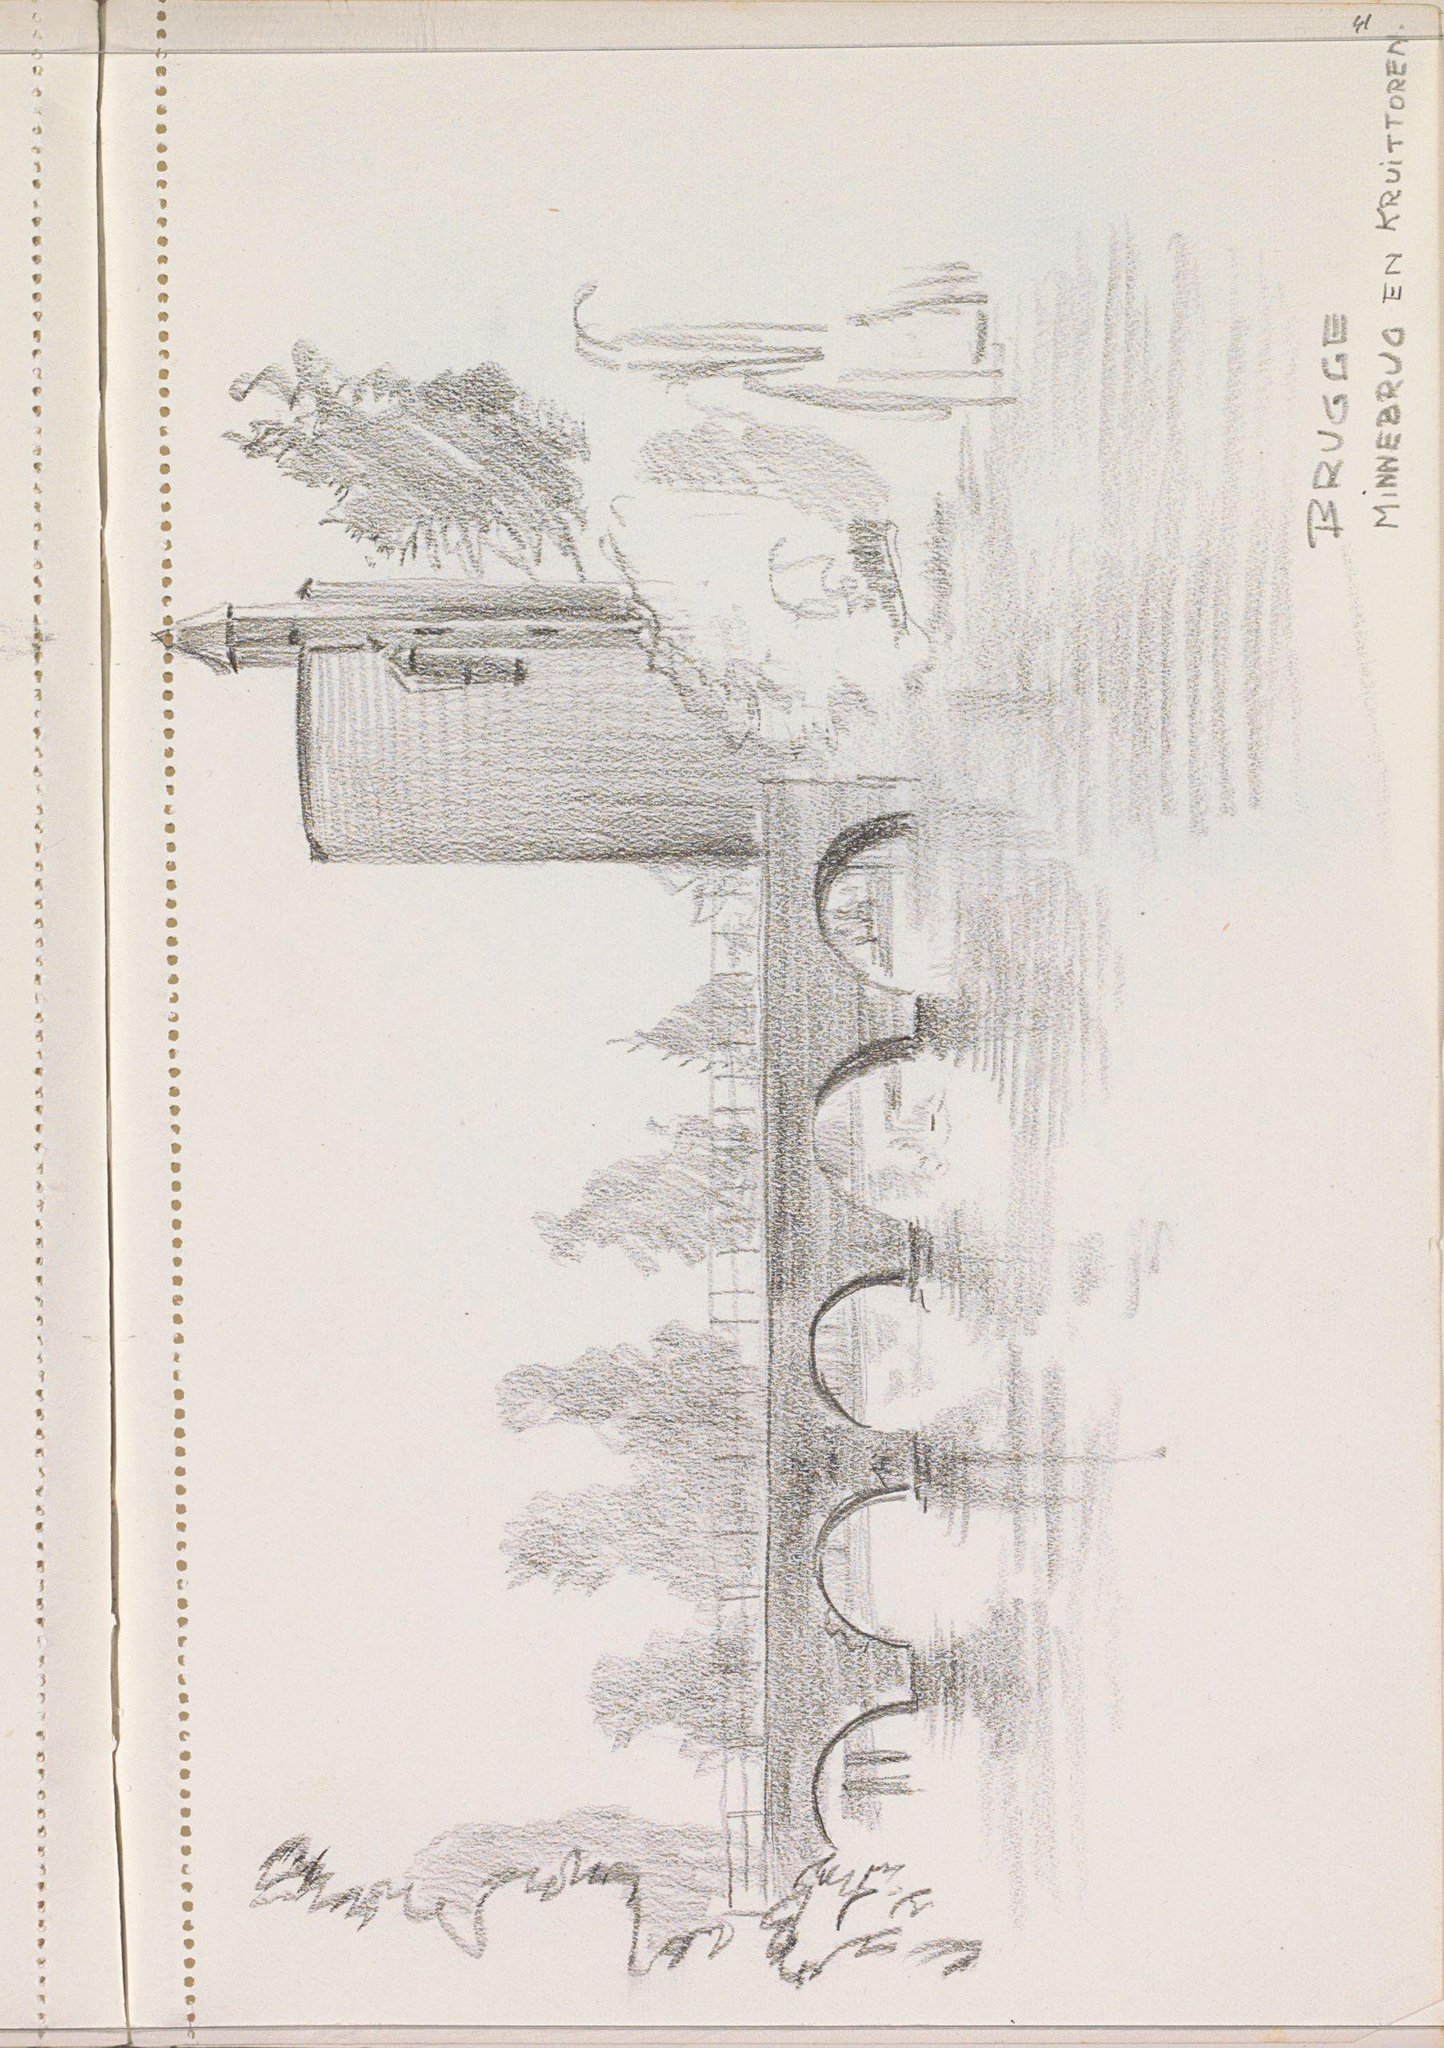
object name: sketchbook leaf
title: Minnebrug en Kruittoren te Brugge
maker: otto verhagen (i)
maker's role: draughtsman, print maker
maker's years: 1885-1951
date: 1930-1940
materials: chalk, paper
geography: bruges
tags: towers ~ fortified city, bridge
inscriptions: annotation: ‘BRUGGE/ MINNEBRUG EN KRUITTOREN.’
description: Pagina 41 uit een schetsboek met 60 bladen.